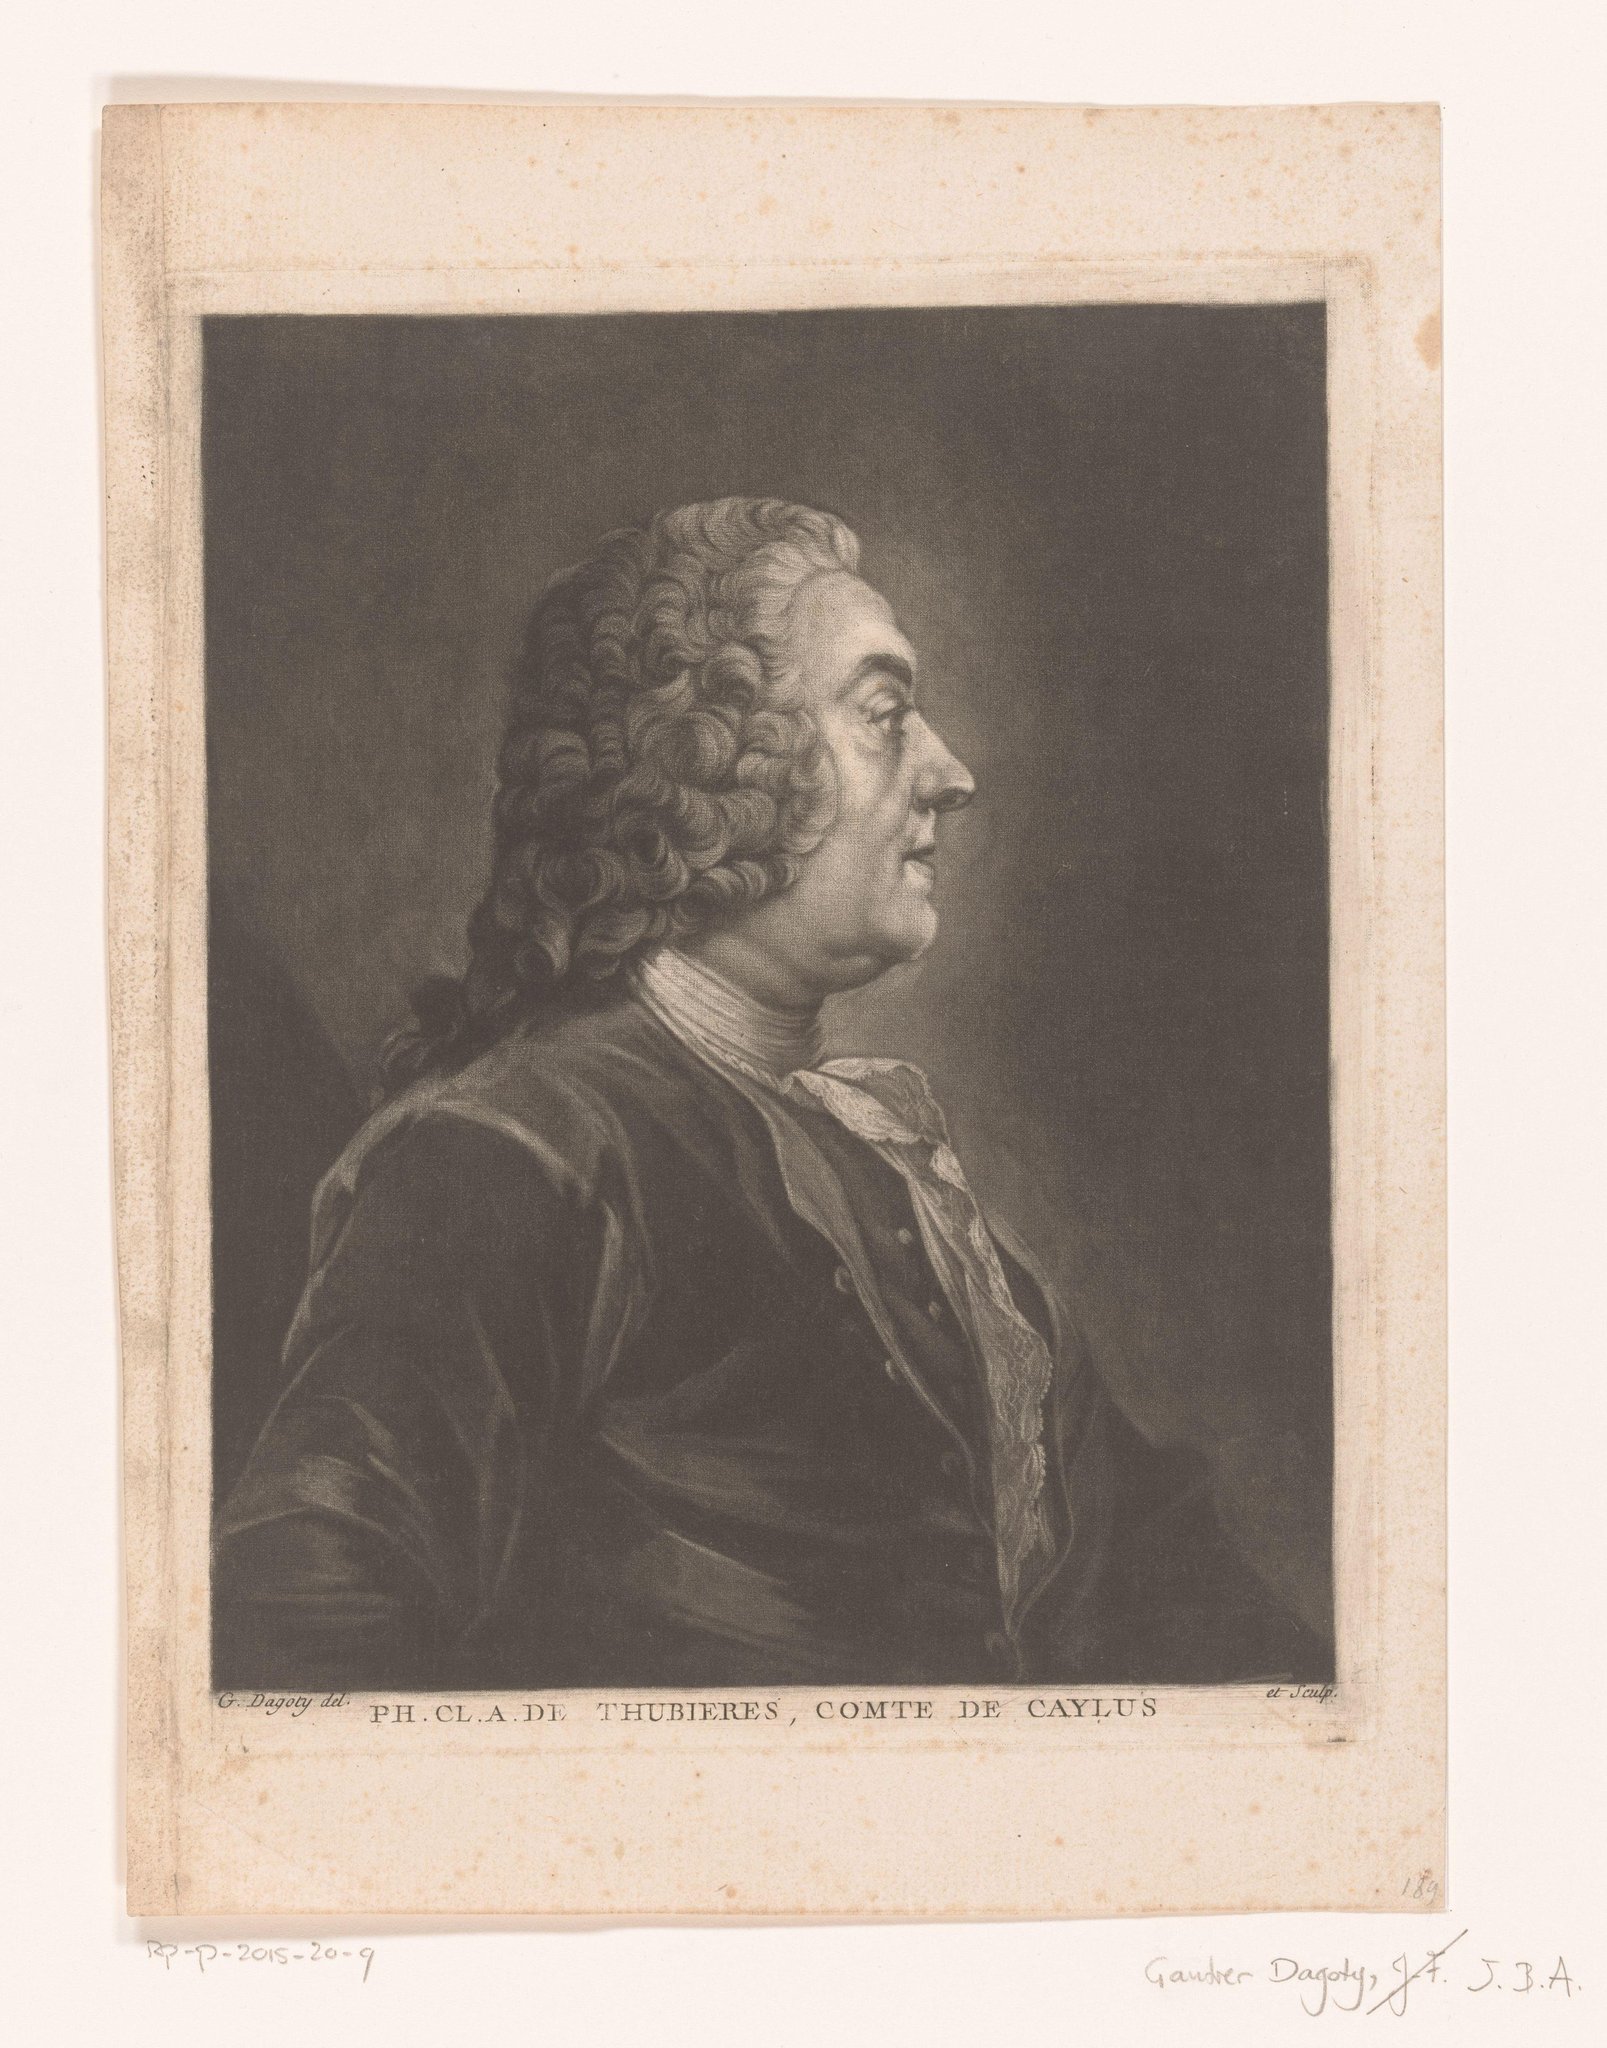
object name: print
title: Portret van Anne Claude Philippe Caylus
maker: jean-baptiste-andré gautier dagoty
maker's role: painter, print maker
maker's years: 1740-1786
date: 1750-1786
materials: paper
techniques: mezzotint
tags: paris, print maker, anne claude philippe caylus, historical persons, portrait, self-portrait of graphic artist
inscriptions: collector's mark: Lugt 2228, collector's mark: Lugt 2760